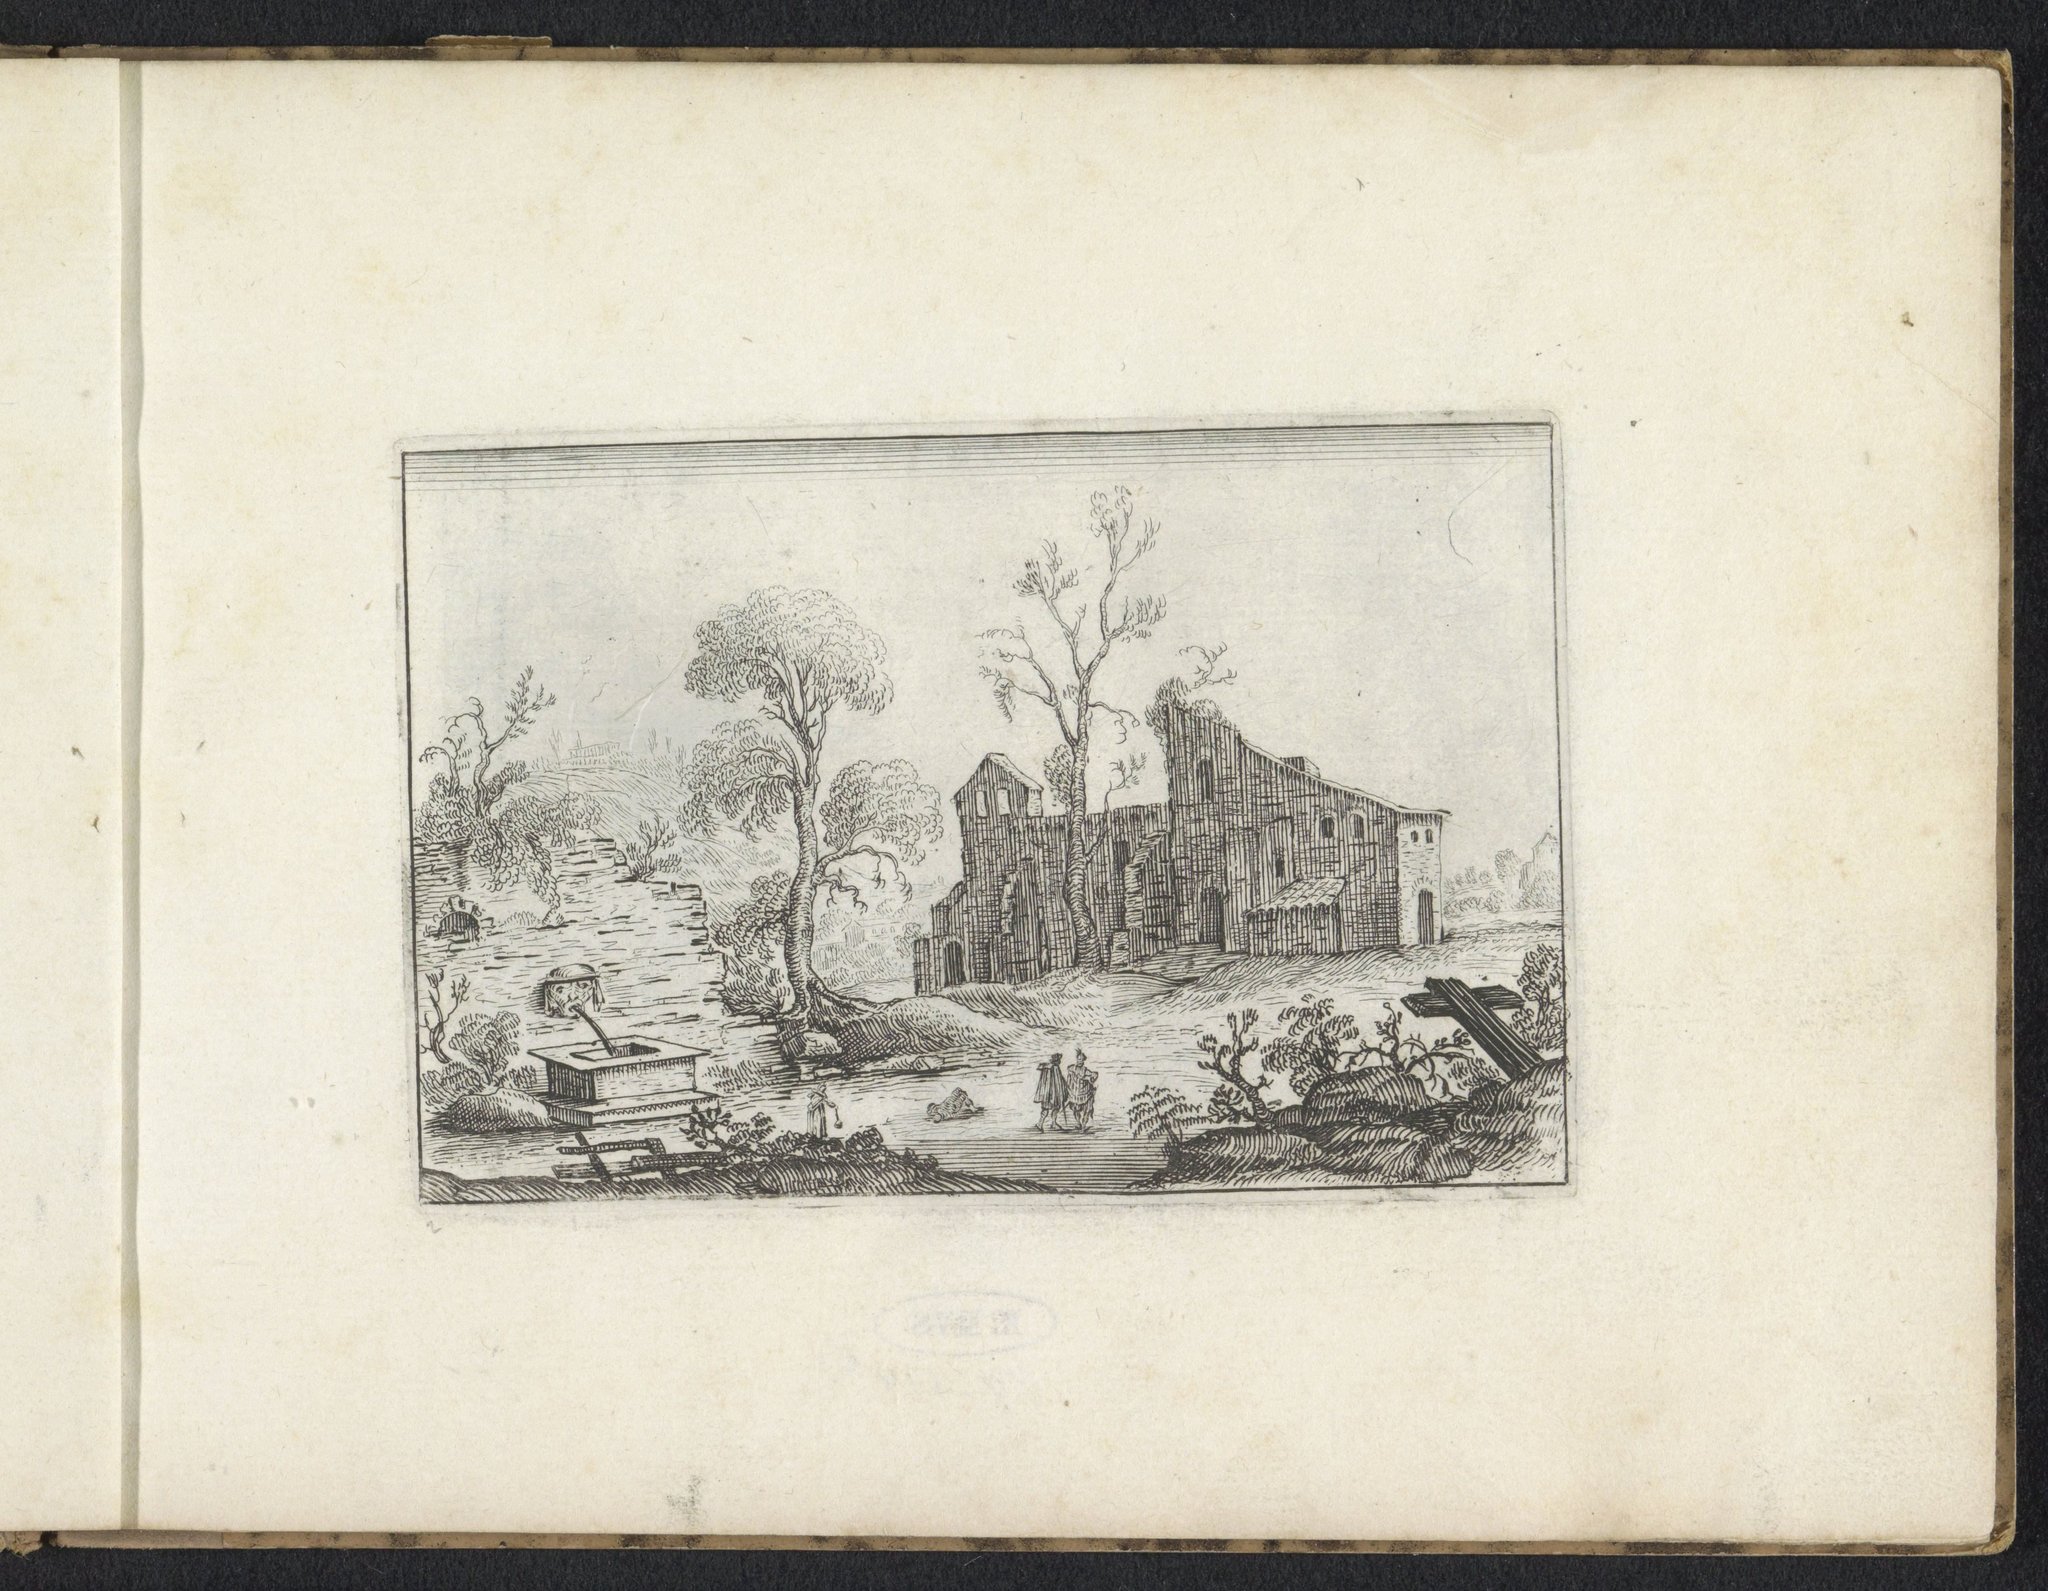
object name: album leaf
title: Landschap met een muurfontein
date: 1610-1638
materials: paper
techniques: etching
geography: northern netherlands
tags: city-view, and landscape with man-made constructions, landscapes, ornamental fountain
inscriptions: collector's mark: Lugt 2228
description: Landschap met een muurfontein en een stenen gebouw. De prent maakt deel uit van een album.